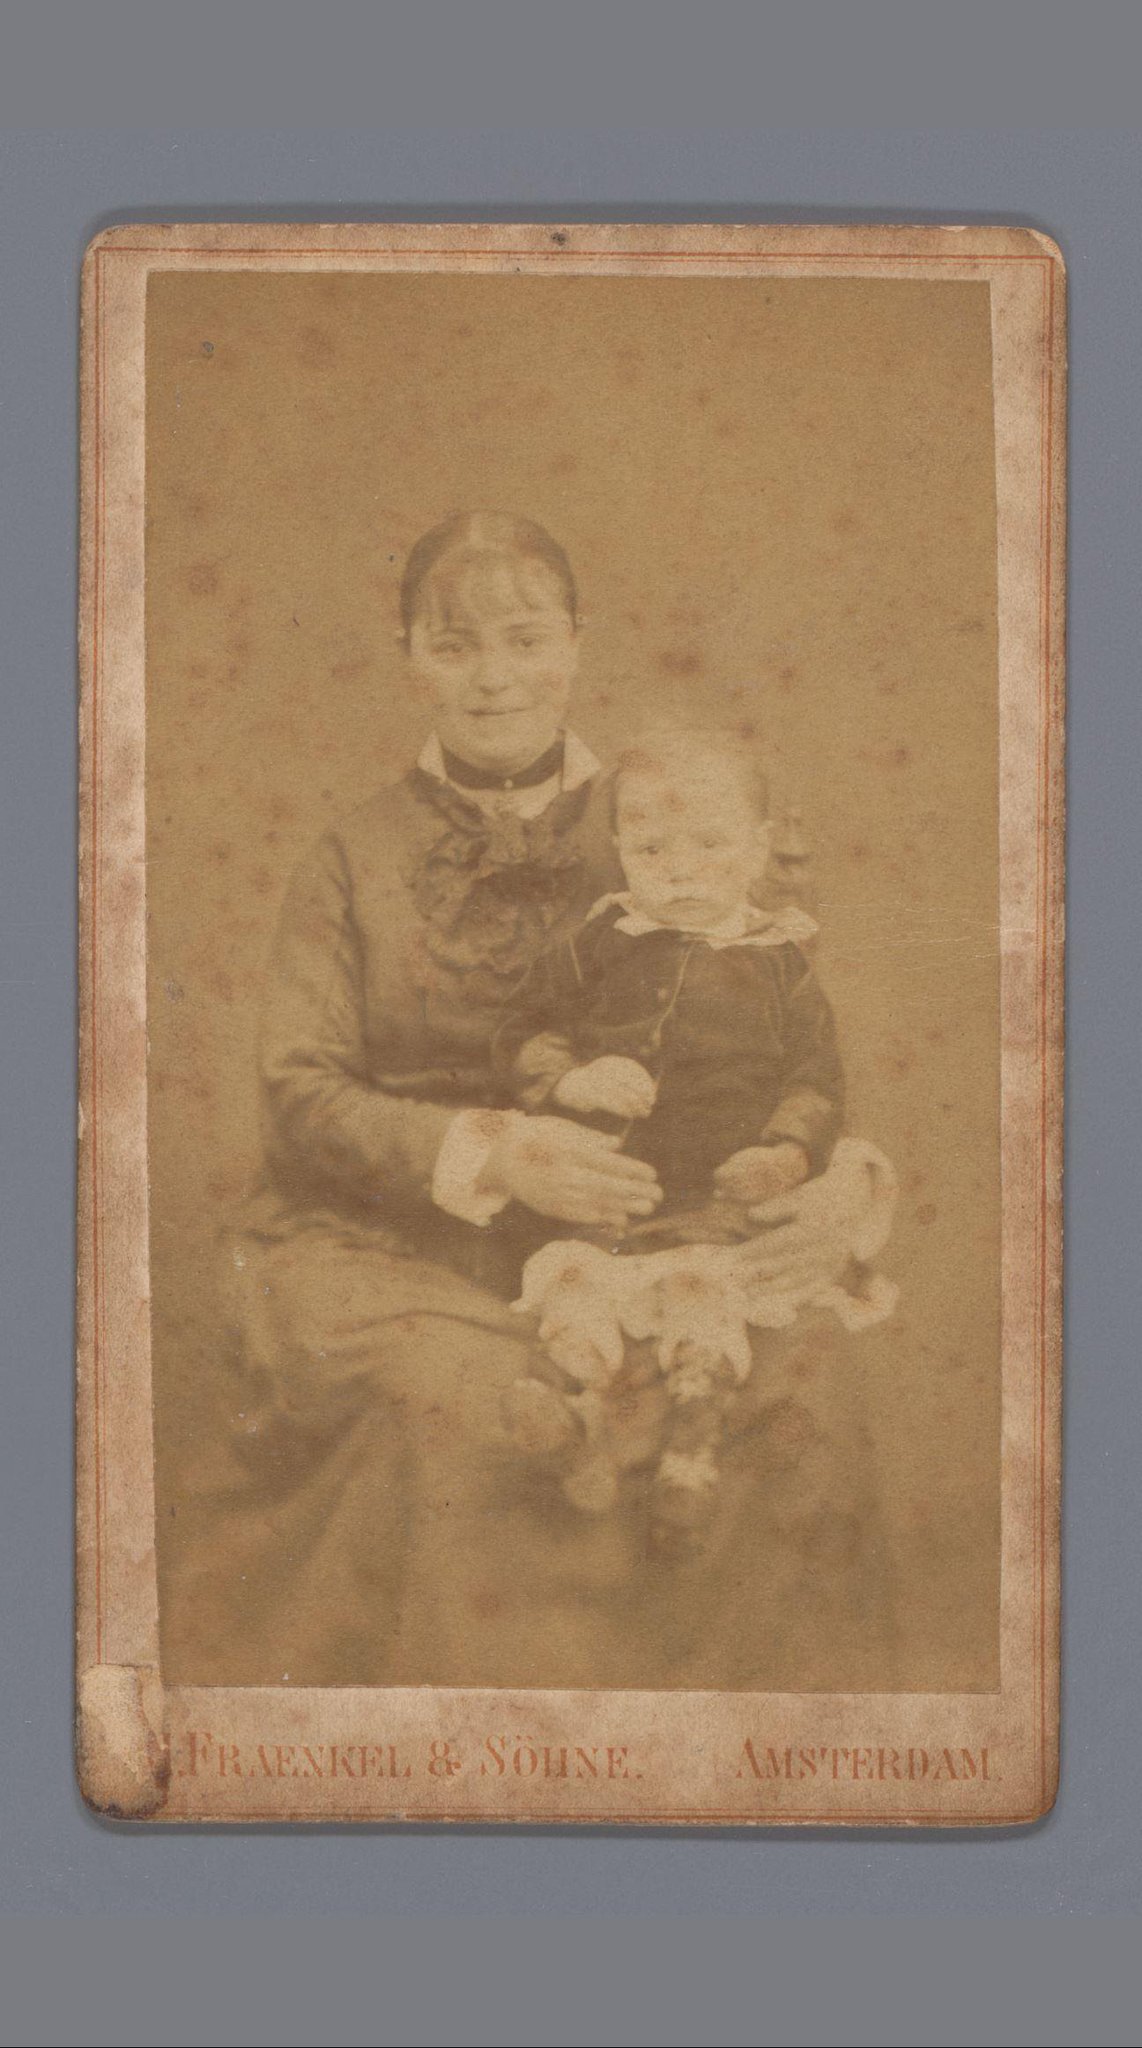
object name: carte de visite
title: Portret van een onbekende vrouw met kind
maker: hironimus fraenkel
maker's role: fotograaf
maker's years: 1811-1887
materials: cardboard, paper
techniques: albumen print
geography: amsterdam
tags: anonymous historical person portrayed, mother and baby or young child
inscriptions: inscription: ‘De Plaat blijft tot Nabestelling bewaard’, address: ‘2e Utrechtschestraat/ tusschen de Heeren en Keizersgrachten/ Y. 47.’